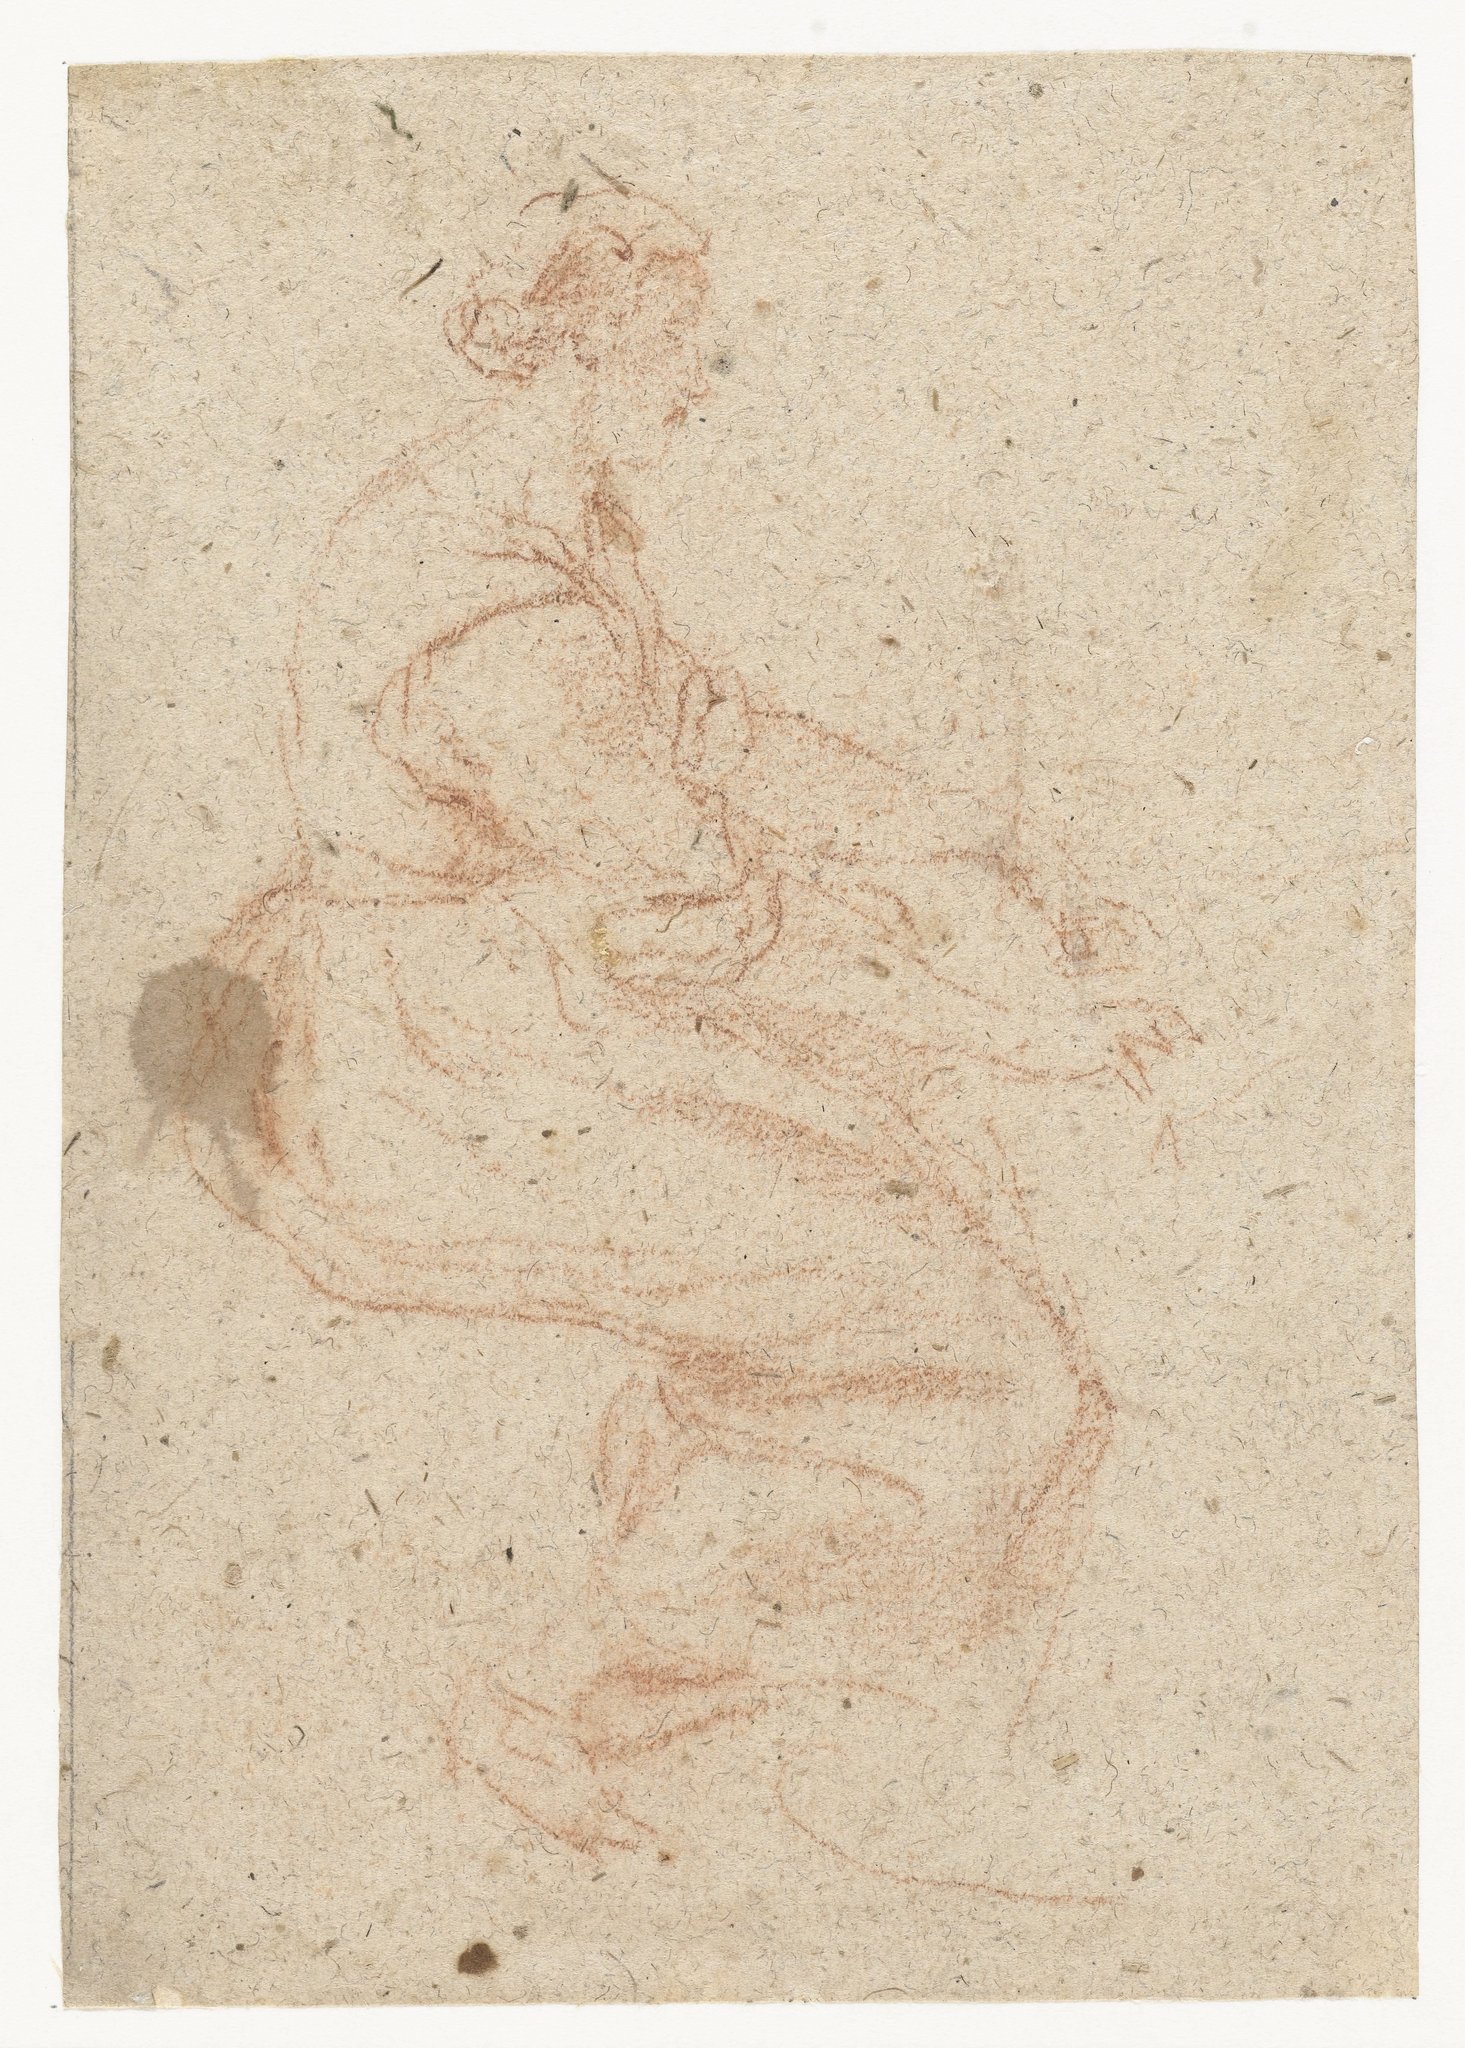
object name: drawing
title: Studie van een zittende vrouw (H. Cecilia ?)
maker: peter paul rubens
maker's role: draughtsman, painter, print maker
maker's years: 1577-1640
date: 1600-1690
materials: chalk, paper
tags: one person playing keyboard instrument, sitting figure - aa - female human figure, st. cecilia making music and/or singing, keyboard instruments